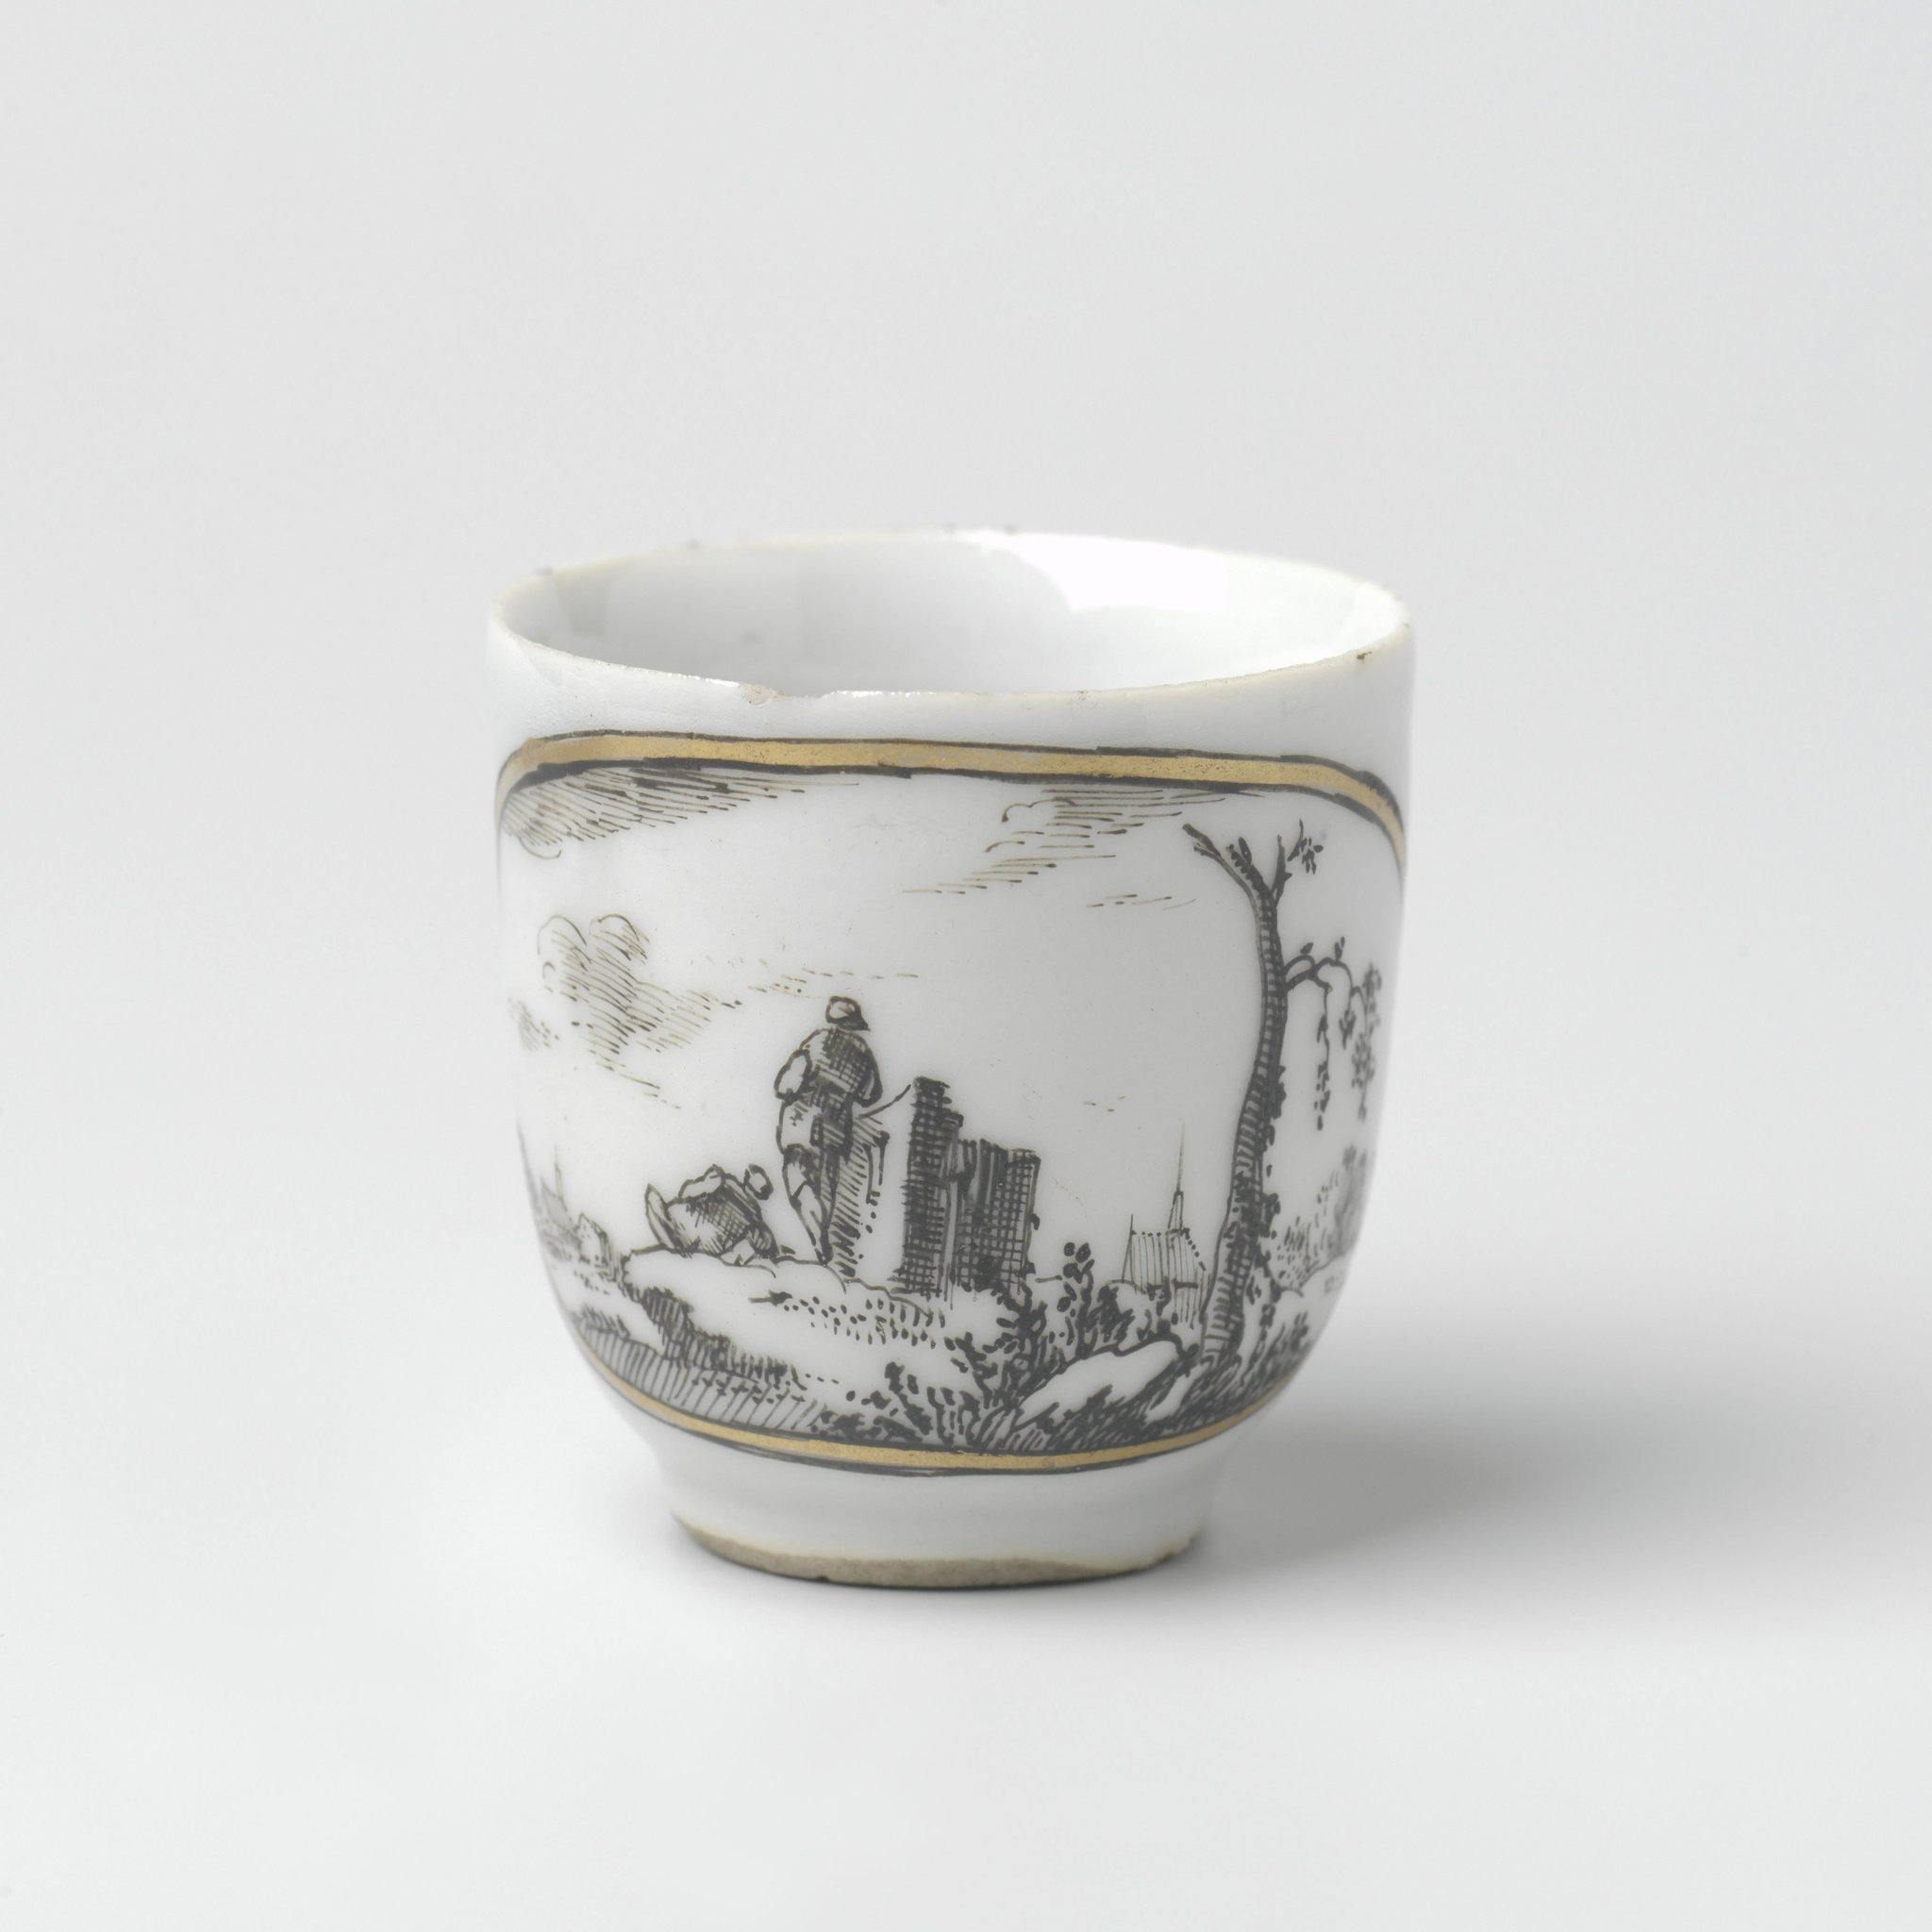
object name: oorkop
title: Cup with handle with European landschape in a medallion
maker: Anonymous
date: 1745-1760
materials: glaze, gold, paint, porcelain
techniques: firing, gilding, turning, vitrification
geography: china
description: Oorkop van porselein beschilderd op het glazuur in zwart en goud. Op de buitenwand een Europees landschap met een persoon, gebouwen en bomen in een ovaal medaillon. In Europa gedecoreerd in encre de Chine.